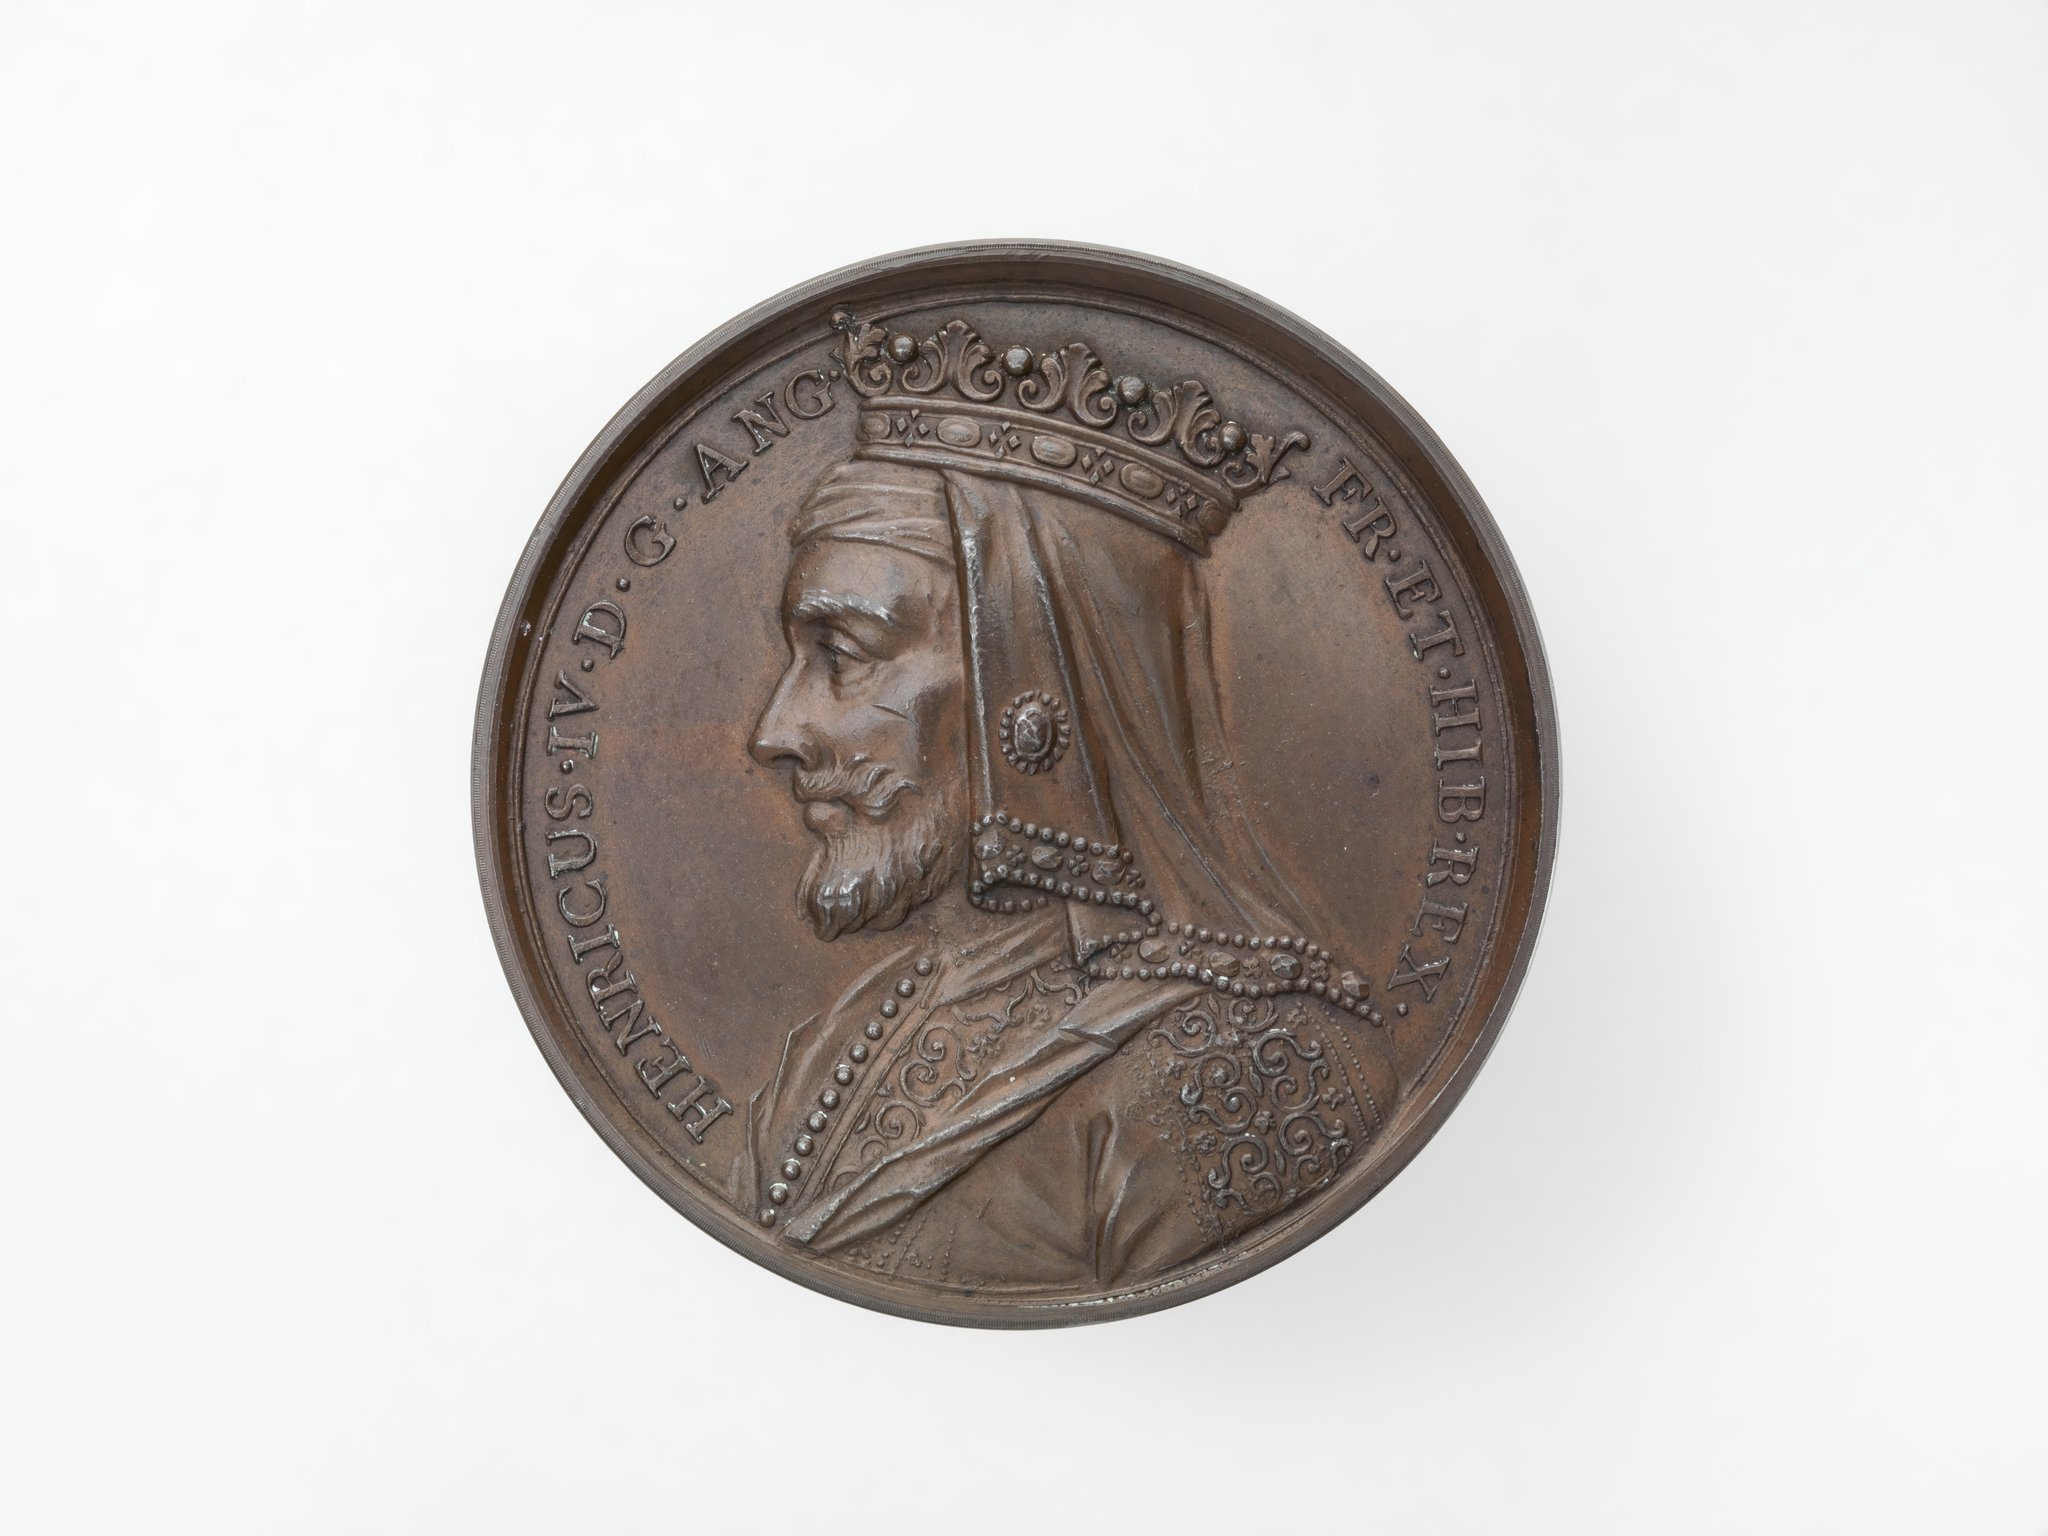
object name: medal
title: Henry IV, from the English Monarchs series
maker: jean dassier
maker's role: artist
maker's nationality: swiss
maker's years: 1676-1763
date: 1731-1732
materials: bronze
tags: men,profiles